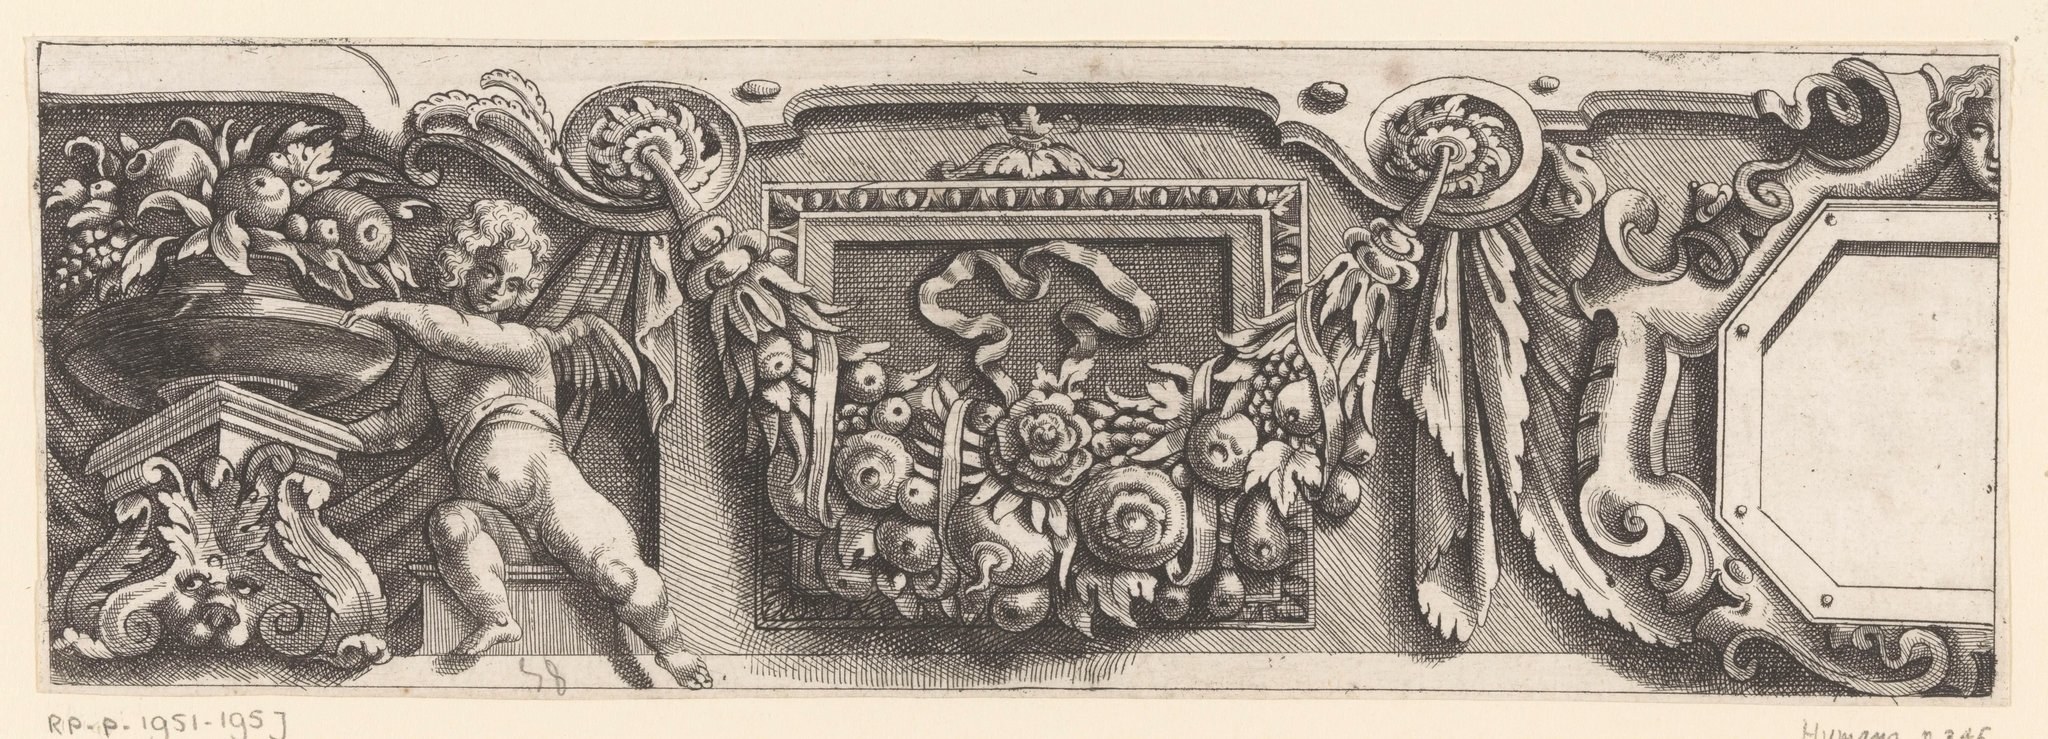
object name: print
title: Friezen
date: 1640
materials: paper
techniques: etching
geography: london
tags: ornament ~ cartouche, flowers in a vase, ornament ~ festoon, garland, cupids: 'amores', 'amoretti', 'putti'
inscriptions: collector's mark: Lugt 2228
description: Een fries met links een zittende putto met een bloemenvaas, in het midden een fruitguirlande en rechts een halve cartouche met masker.